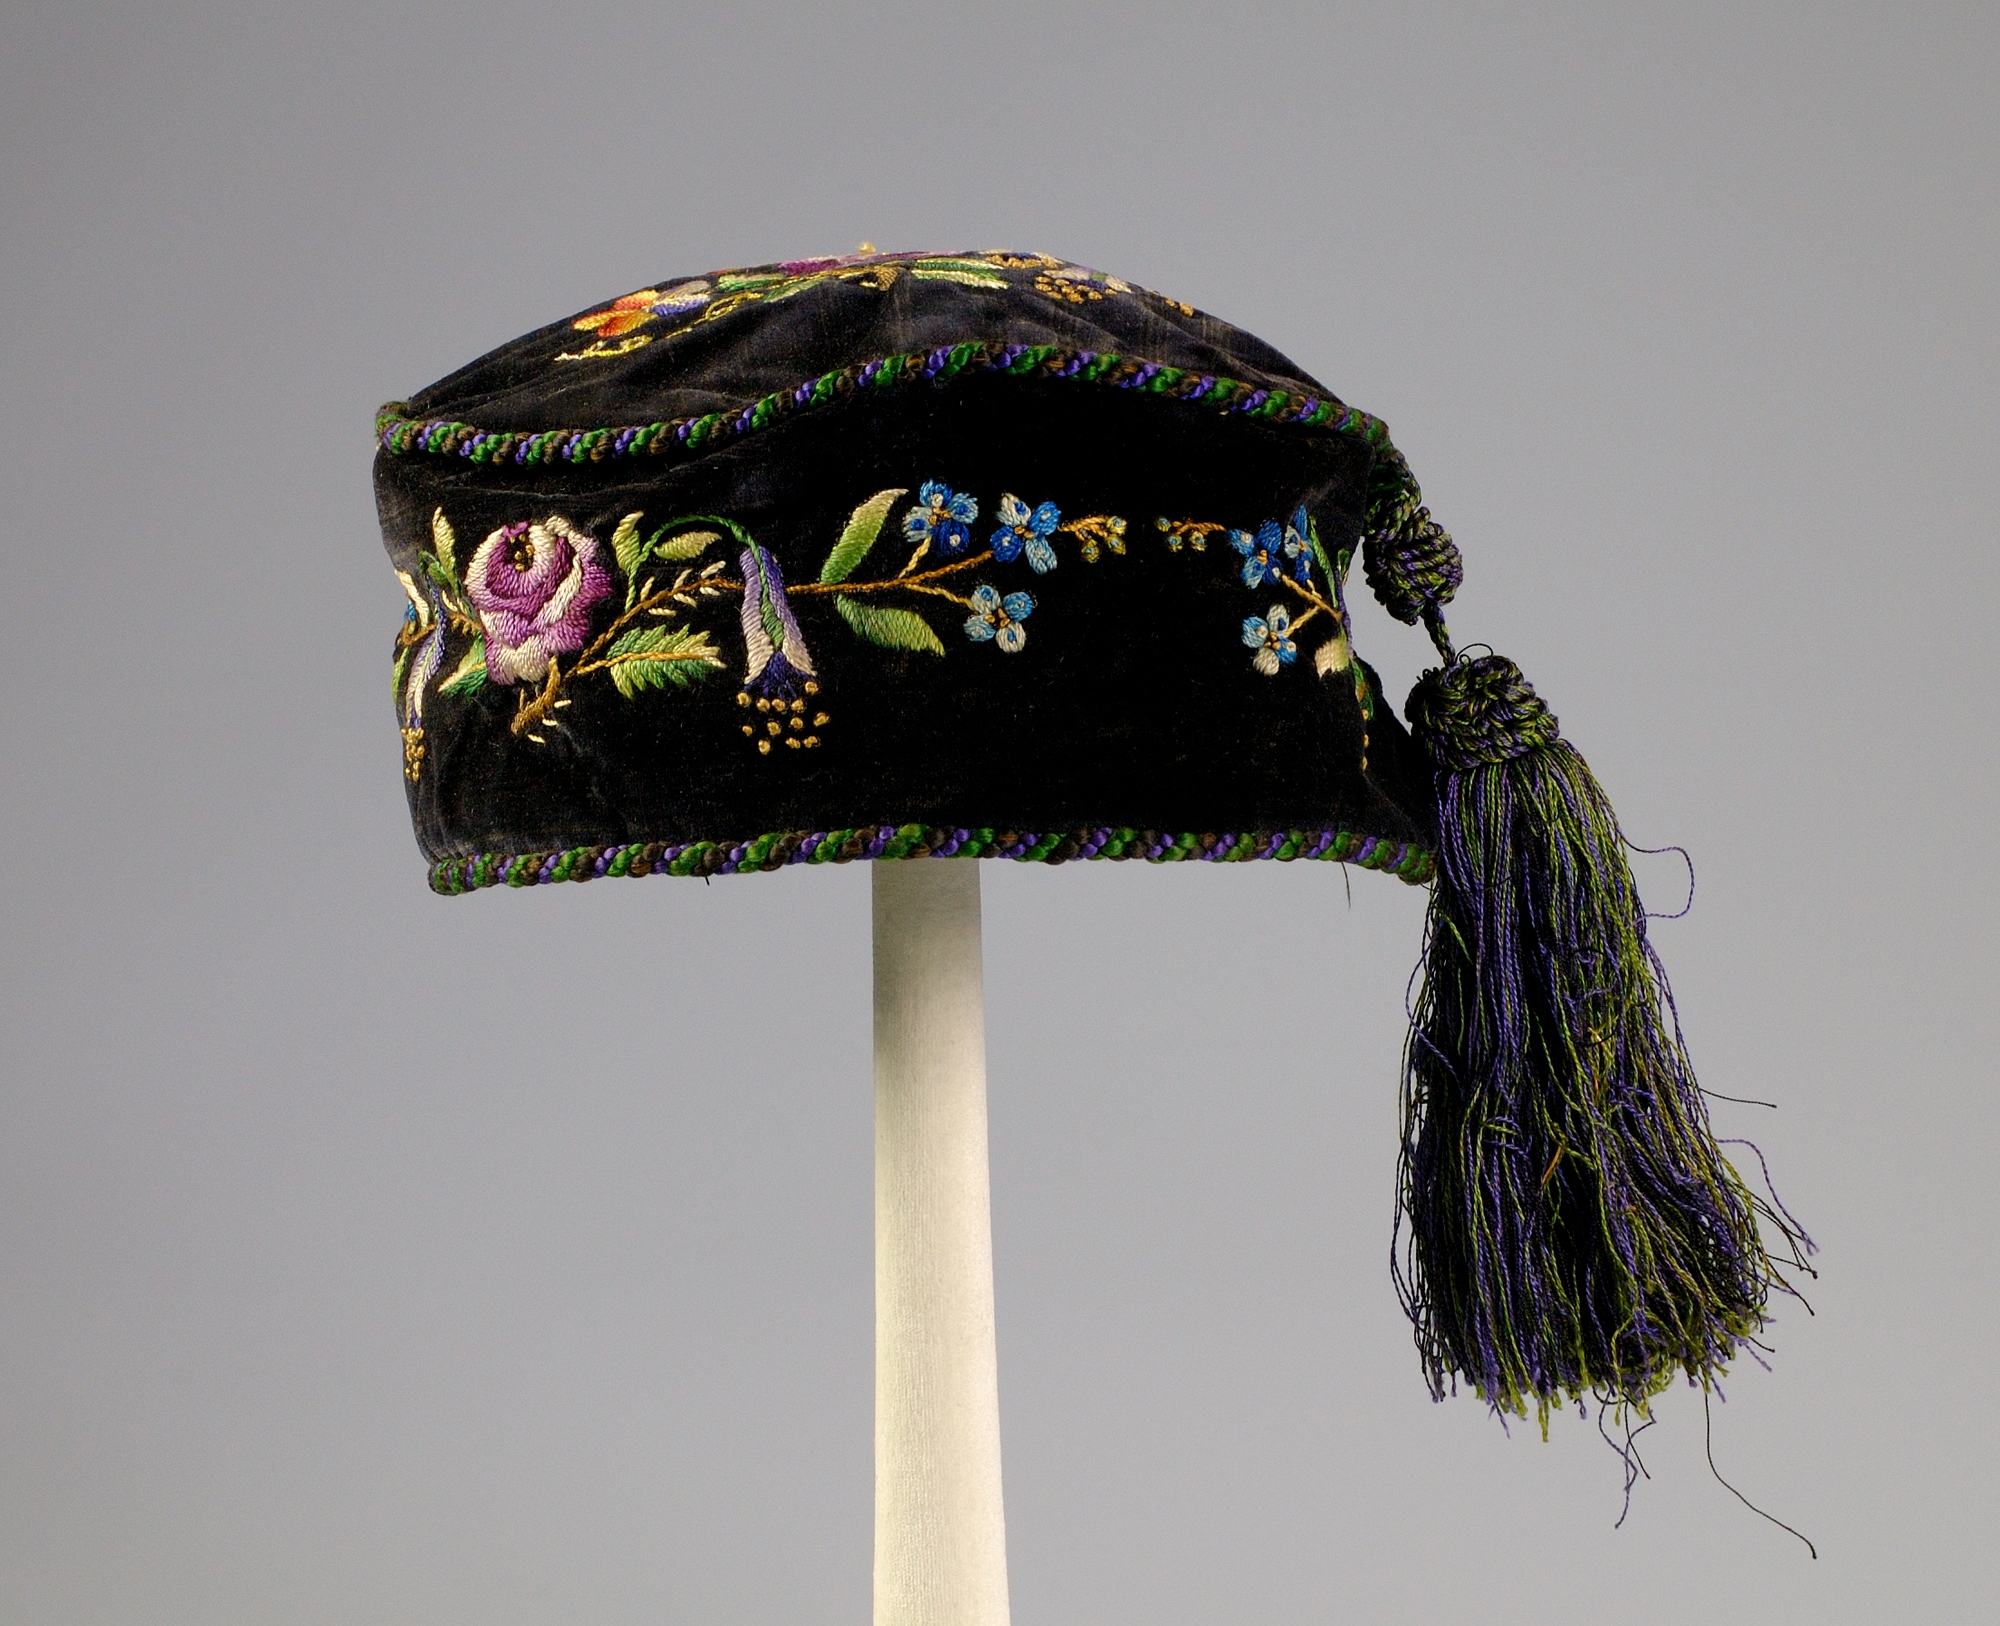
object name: cap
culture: american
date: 1875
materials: cotton, silk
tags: flowers